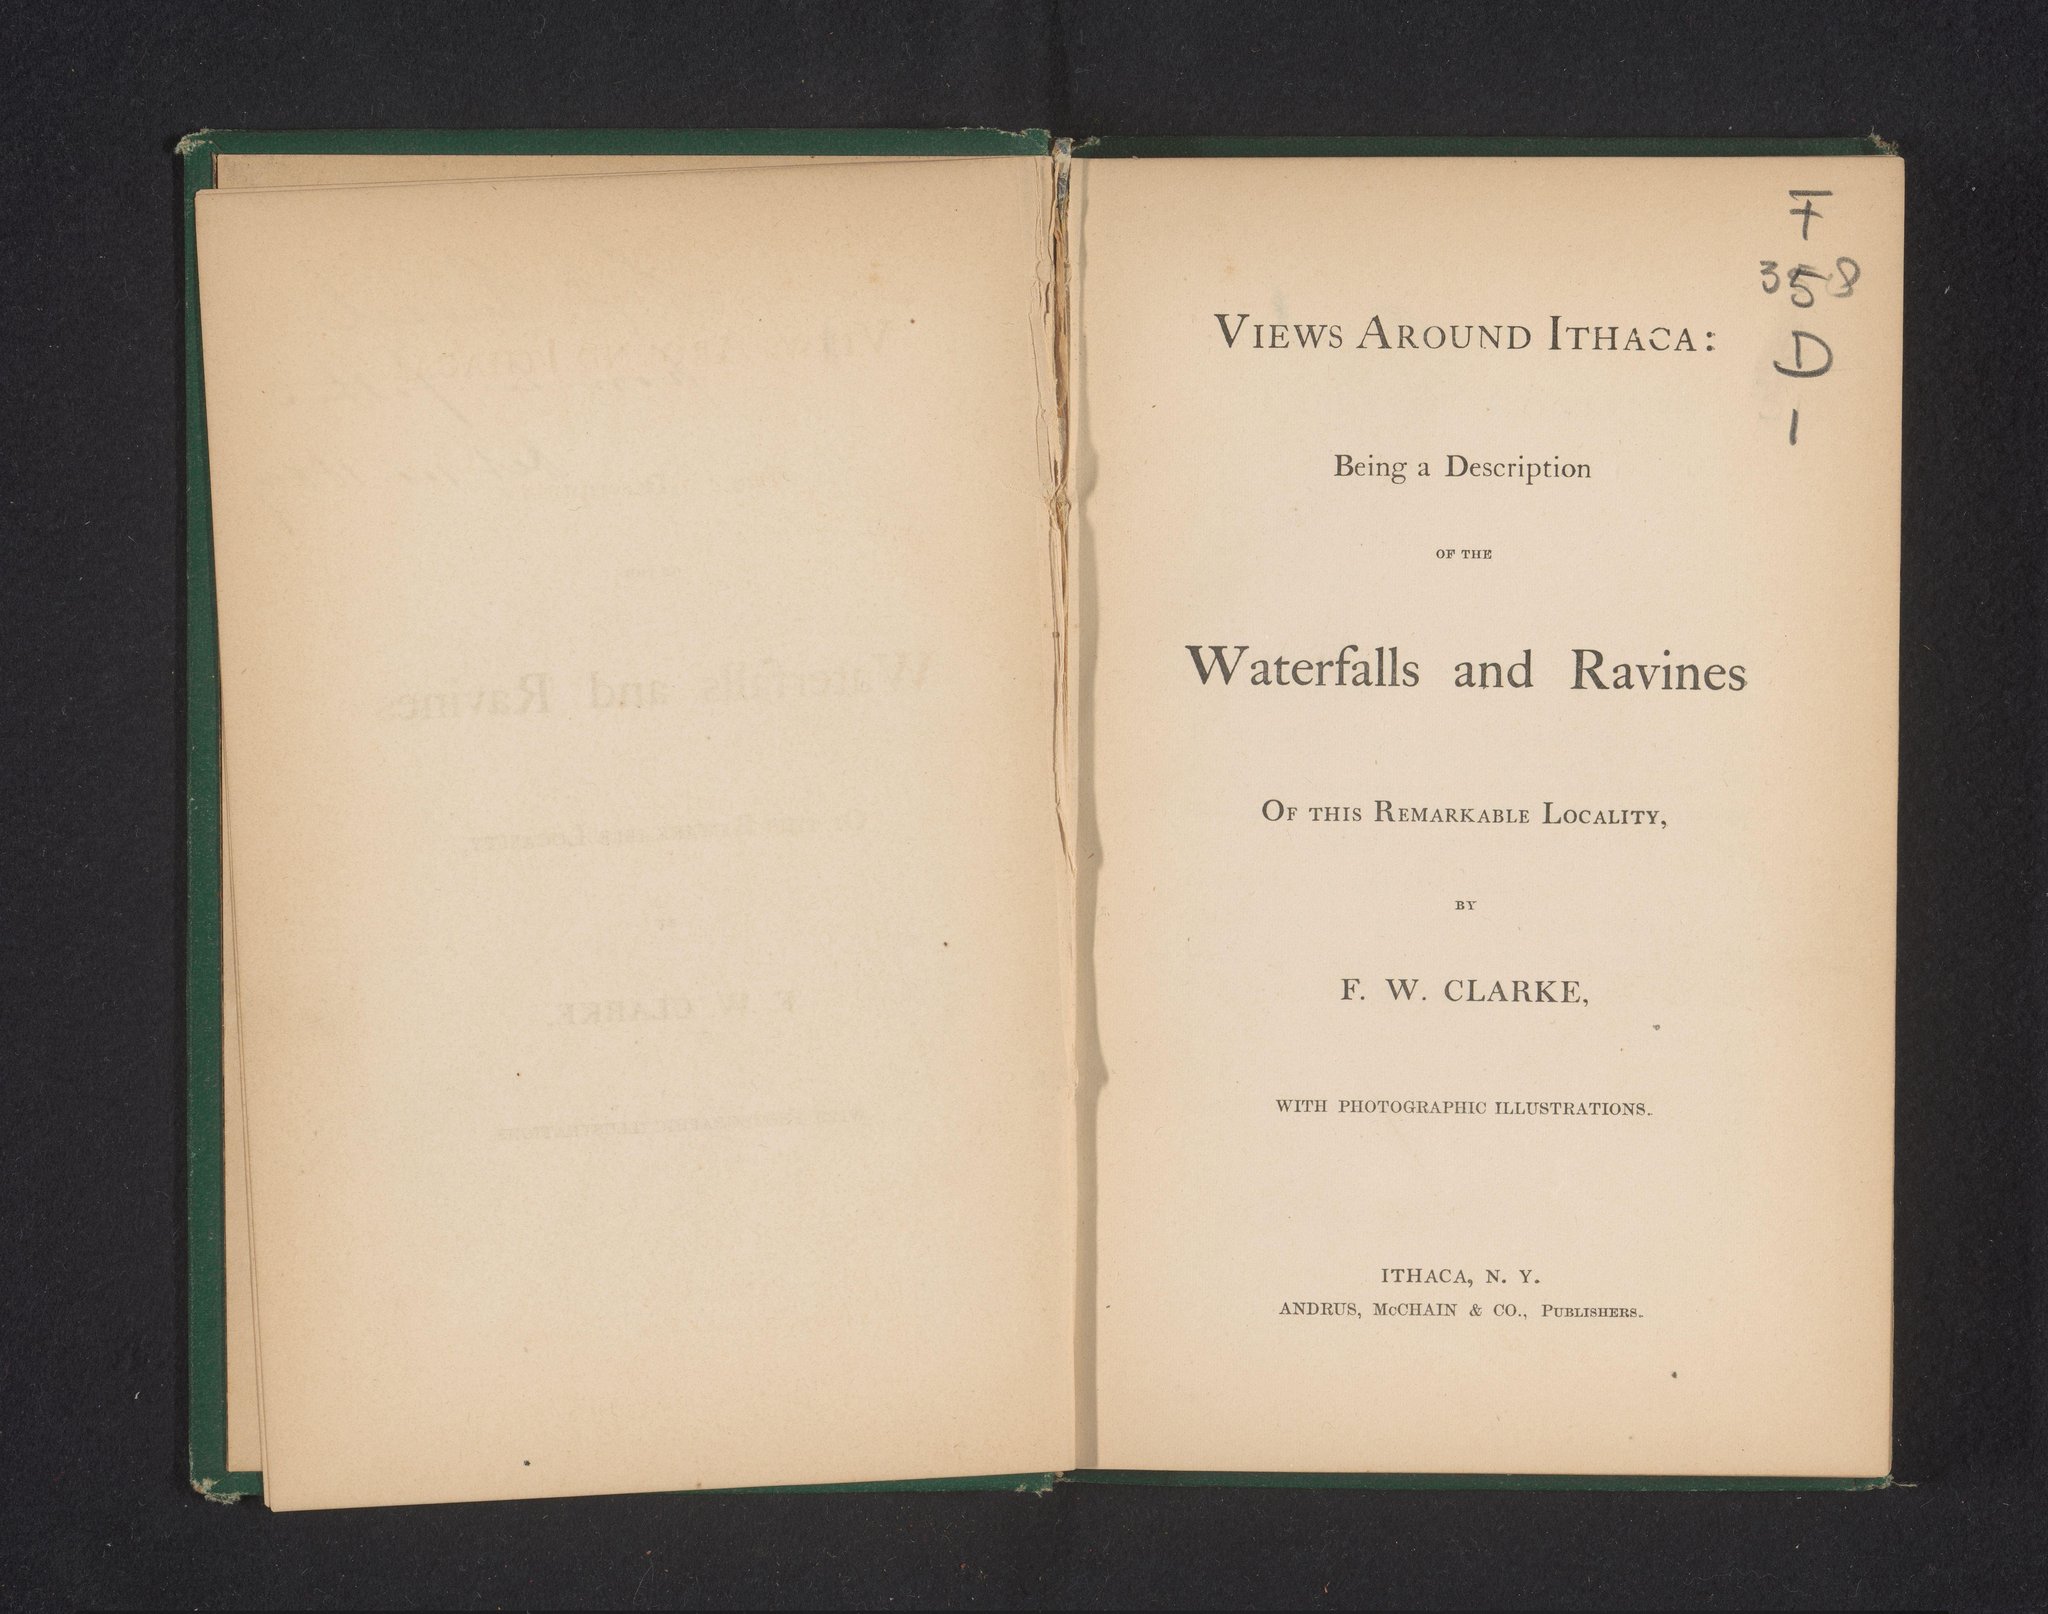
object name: book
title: Views around Ithaca: being a description of the waterfalls and ravines of the remarkable locality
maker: frank wigglesworth clarke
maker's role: schrijver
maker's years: 1847-1931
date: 1869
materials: cardboard, linen, paper, photographic support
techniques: albumen print, printing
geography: ithaca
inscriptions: inscription: ‘Lot 54’, inscription: ‘S.J. Russel from her father Oct.14.1869’